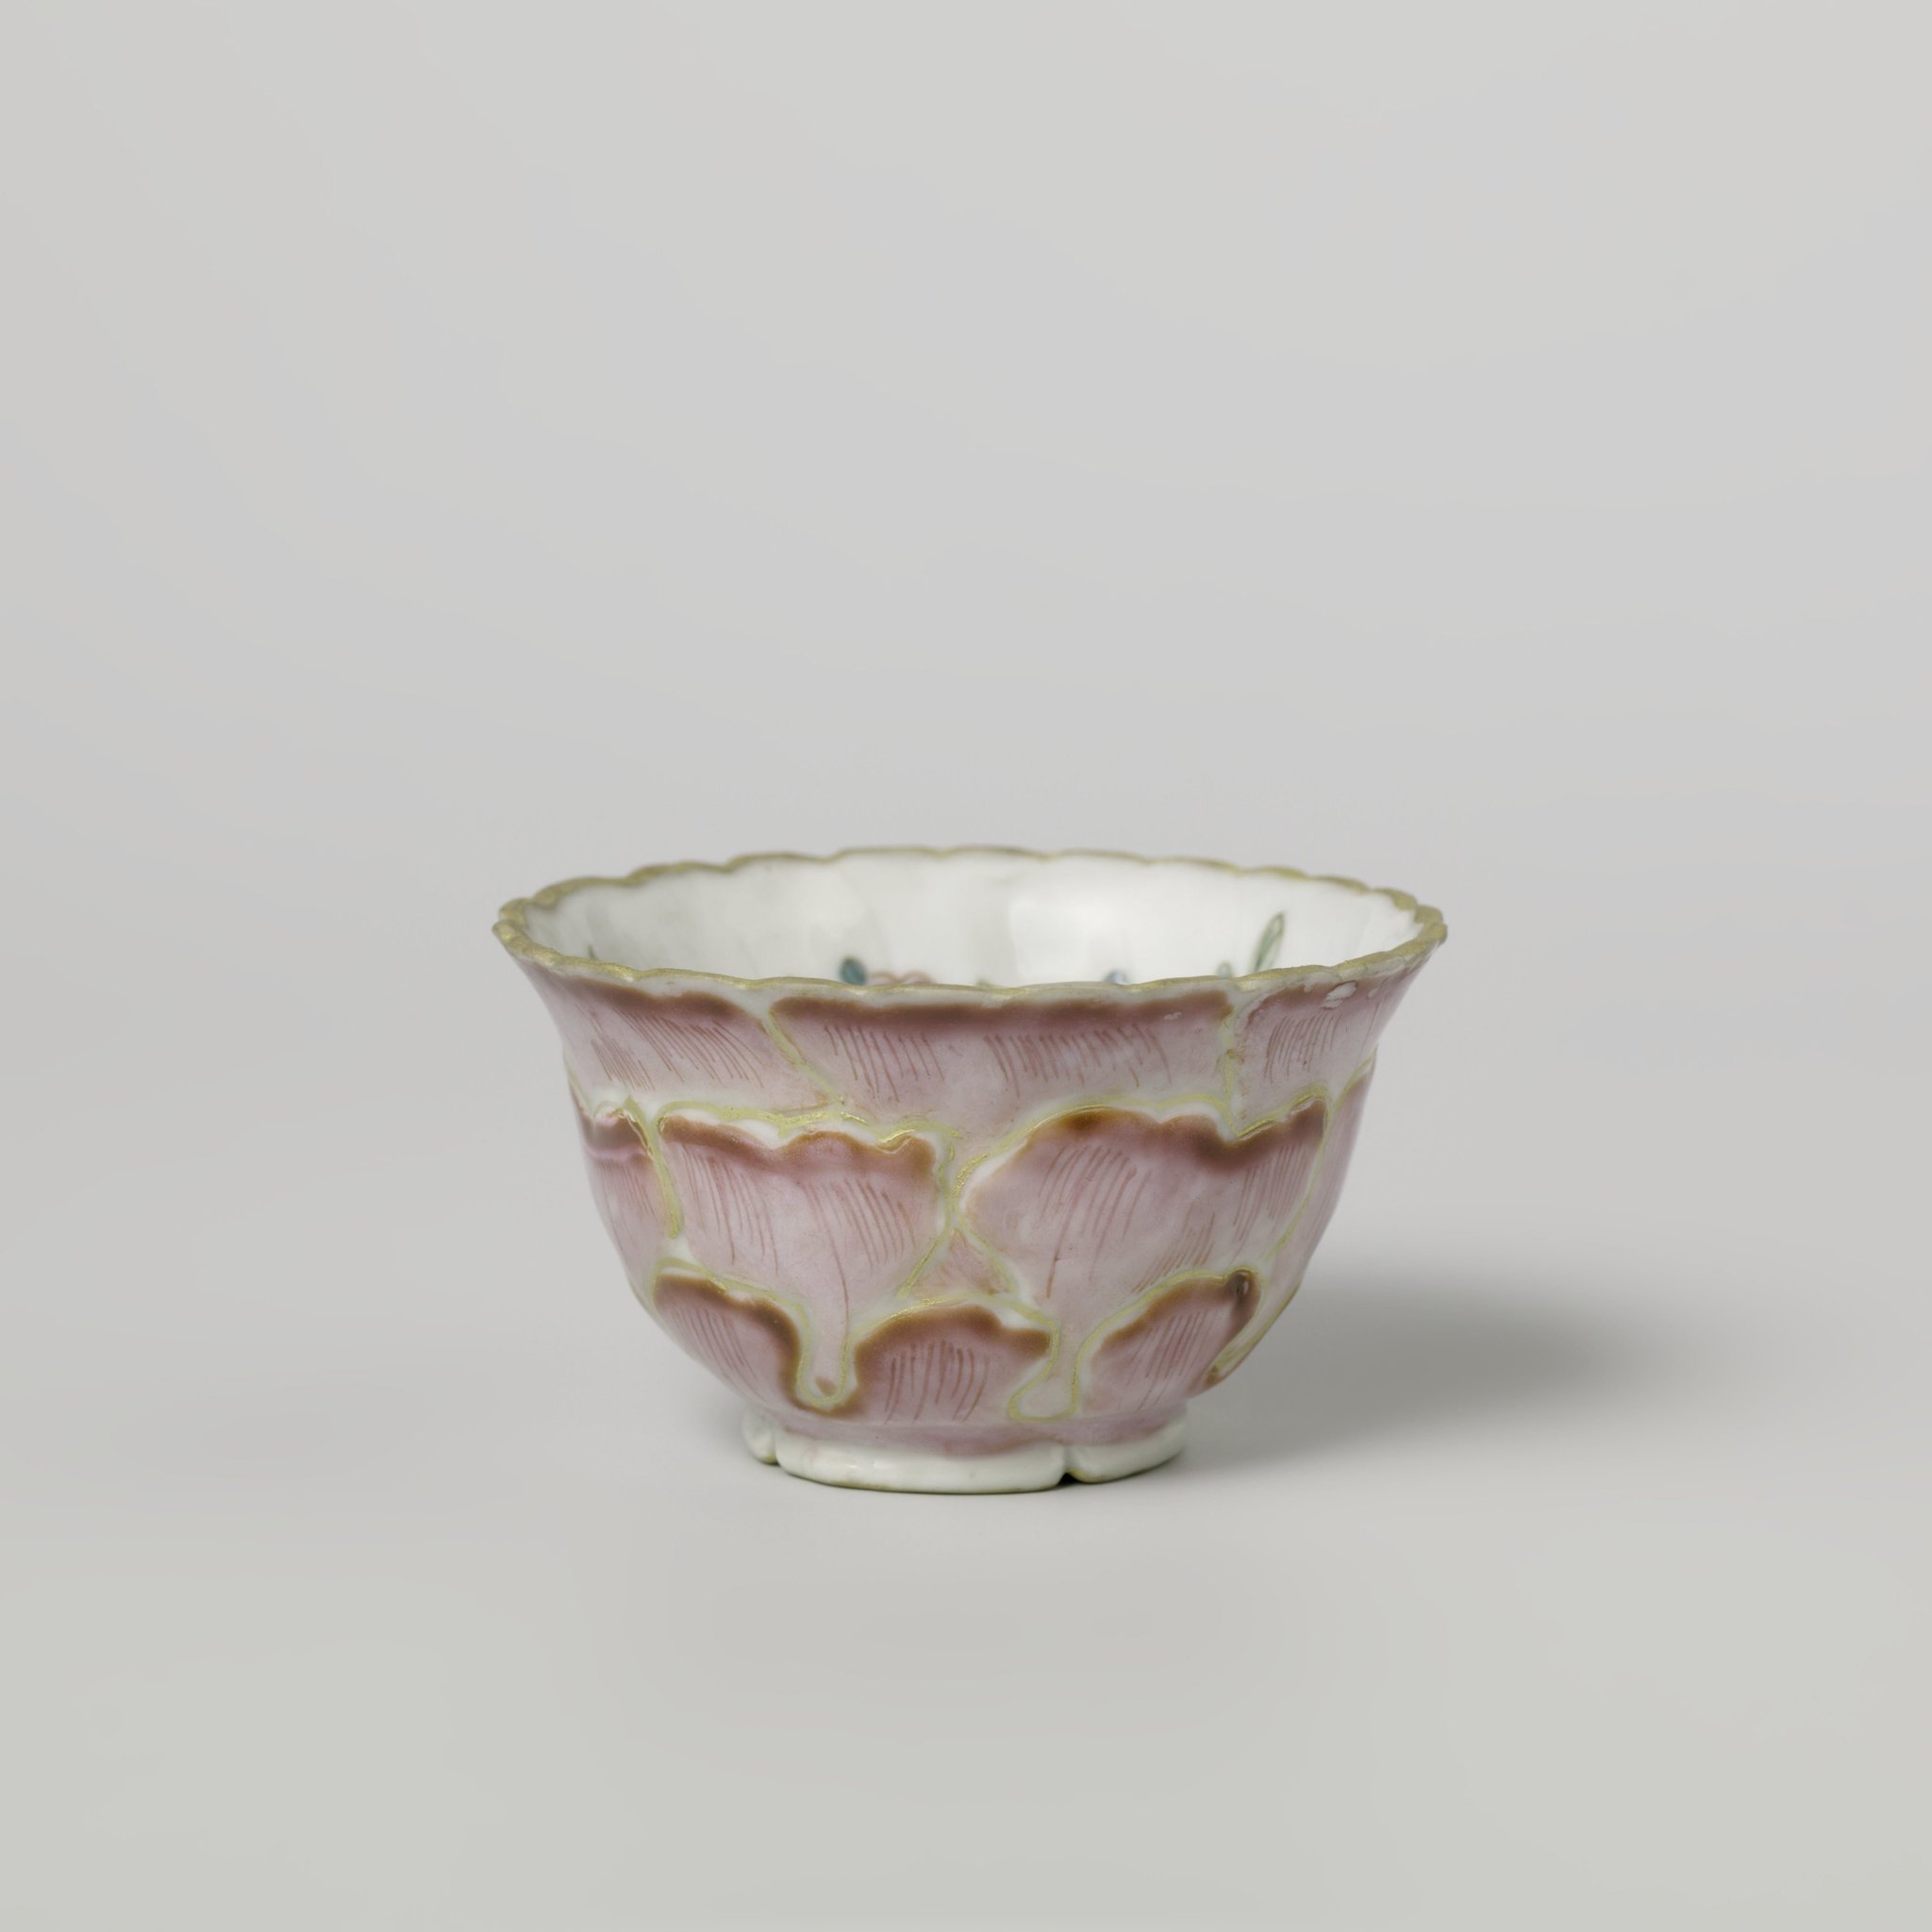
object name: cup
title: Bell-shaped cup modelled in the shape of a flower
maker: Anonymous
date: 1740-1760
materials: glaze, gold, paint, porcelain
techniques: firing, gilding, turning, vitrification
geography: china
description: AK-NM-6406 en 6407 Zes koppen en schotels • Famille rose porselein • Onderdeel van Royers porseleincollectie • Mogelijk afkomstig van Susanna Louise Huygens De koppen en schotels zijn gevormd als zich openende bloemblaadjes en de stengels en blaadjes vormen de voet van de schotels. Het navolgen van elementen uit de natuur kwam bij het vormen van keramiek in China vaker voor. Royer had daar zelf voorbeelden van bij zijn Yixing theepotten (AK-NM-6568 en -6580 bijvoorbeeld) en bij zijn blanc de Chine porselein (de bakjes AK-NM-6534). Dit soort theegoed dat in vrij veel andere collecties ook te vinden is en waar dus blijkbaar enthousiasme voor bestond onder de Europese kopers, volgt hetzelfde principe, maar is verder gestandaardiseerd en – mede door de beschildering – een tikje kitschiger [Wirgin 1998, nr. 93]. Opvallend is dat juist ook in vorstelijke collecties deze koppen en schotels te vinden zijn: in Londen, Dresden, Kopenhagen [Ayers 2016, vol. I, nrs. 761-766, Reichel 1993, nr. 28, Grandjean 1965, nr. 12, pl. 28]. Informatie over die vorstelijke collecties helpt bij het dateren. In Dresden werden de kopjes tussen 1727 en 1729 geïnventariseerd en in Kopenhagen hebben ze een monogram van koning Christiaan VI die van 1730 tot 1746 regeerde. Ze zijn dus vroeger dan je zou denken. Royer kon ze waarschijnlijk in 1786 overnemen uit de nalatenschap van zijn oudtante Susanna Louise Huygens (1714-1785). In de beschrijving van haar gekleurde porselein vinden we ‘ses paar thee goed, van buiten rood, schulpwerk, en van binnen marseille met bouquetten, de schoteltjes met geboutzeer rankwerk.’ Deze koppen en schotels horen dus bij de porseleinverzameling. Dit in tegenstelling tot de vele koffie- en theeserviezen en losse series theegoed die volgens de boedelbeschrijving opgemaakt na het overlijden van de weduwe Royer, ergens een plek in huis hadden. Bronnen: Bredo L. Grandjean, Dansk Ostindisk porcelaen importen fra Kanton ca. 1700-1822, Kopenhagen, 1965. Friedrich Reichel, Die Porzellansammlung Augusts des Starken: Porzellankunst aus China, die rosa Familie, München, 1993. Jan Wirgin, Fran Kina till Europa. Kinesiska konstföremal fran de ostindiska kompaniernas tid, Stockholm, 1998. John Ayers, Chinese and Japanese works of art in the collection of Her Majesty The Queen, Londen, 2016.